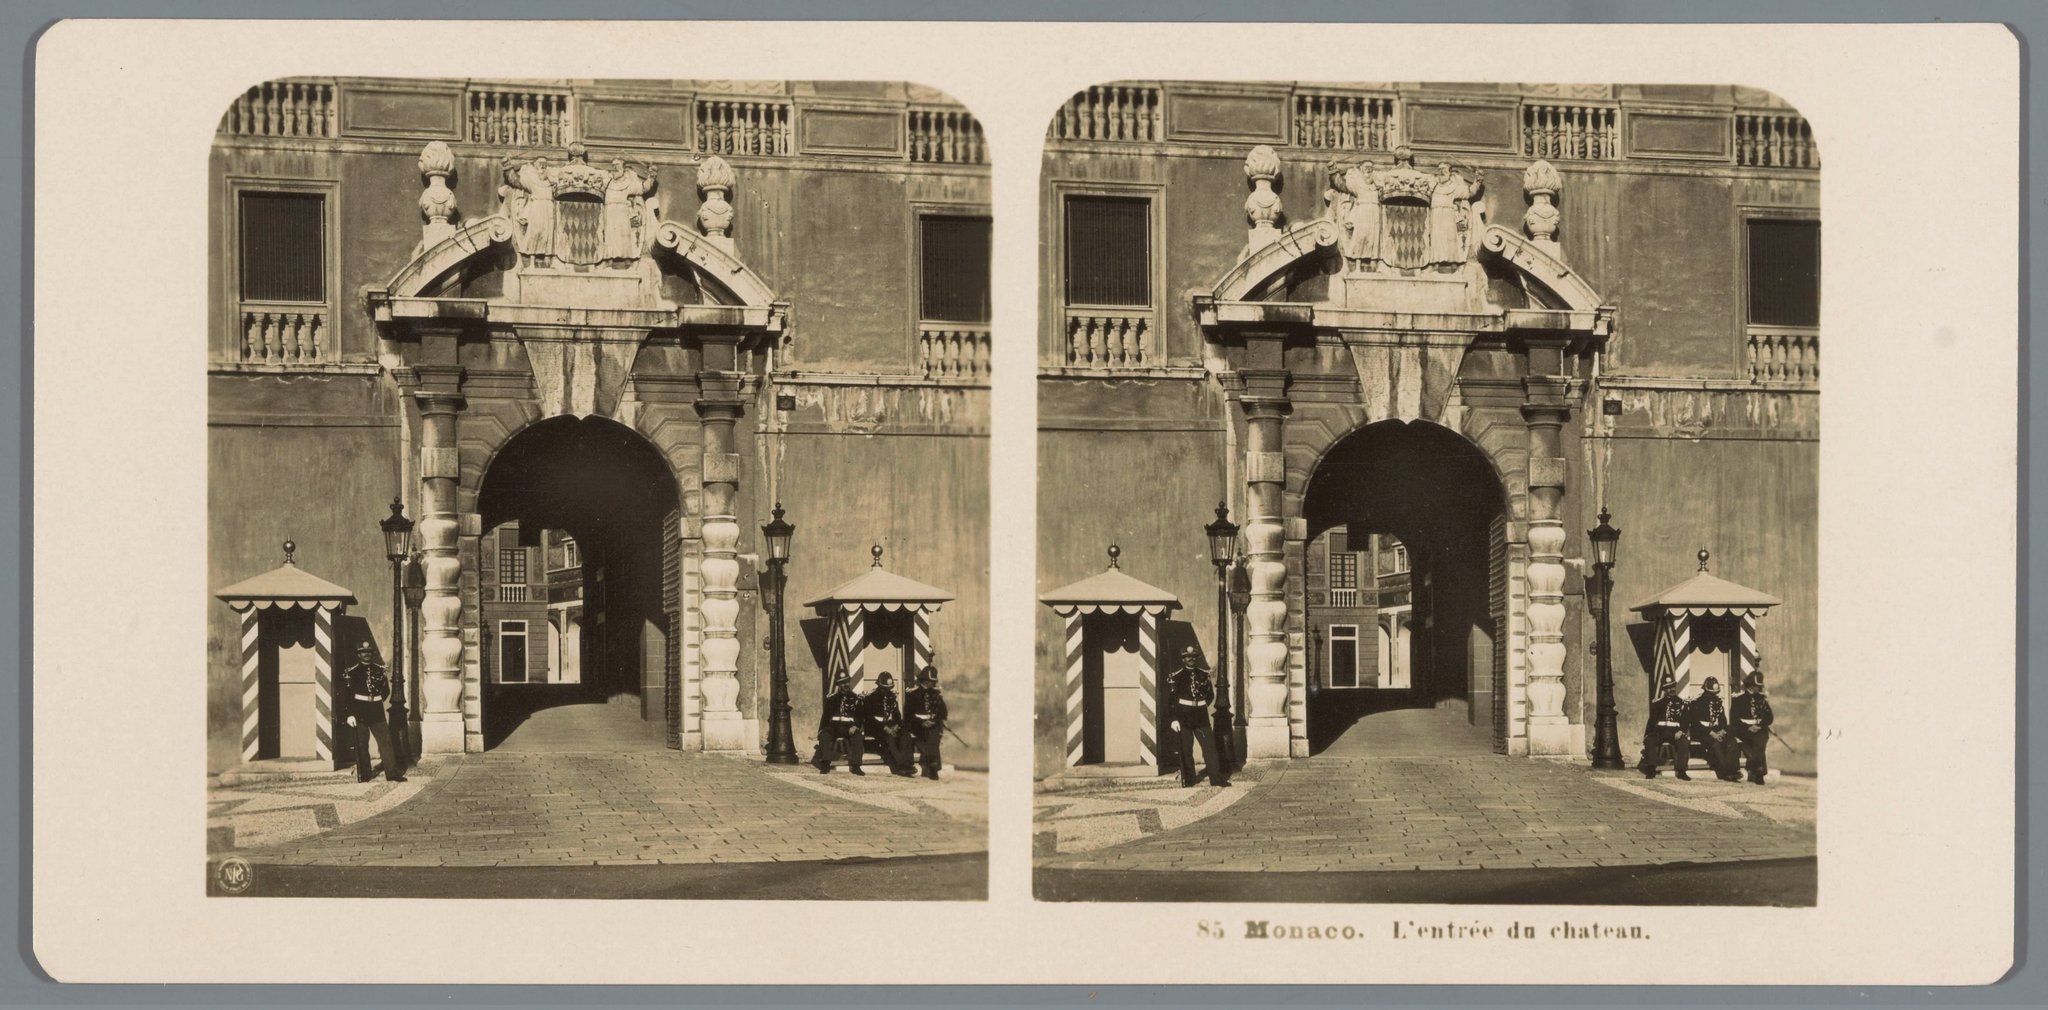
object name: stereograph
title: Monaco. L'entrée du chateau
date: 1900-1910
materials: cardboard, photographic support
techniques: gelatin silver print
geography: monaco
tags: palace, gate, entrance, façade (of house or building)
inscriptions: number: ‘85’, inscription: ‘NPG’